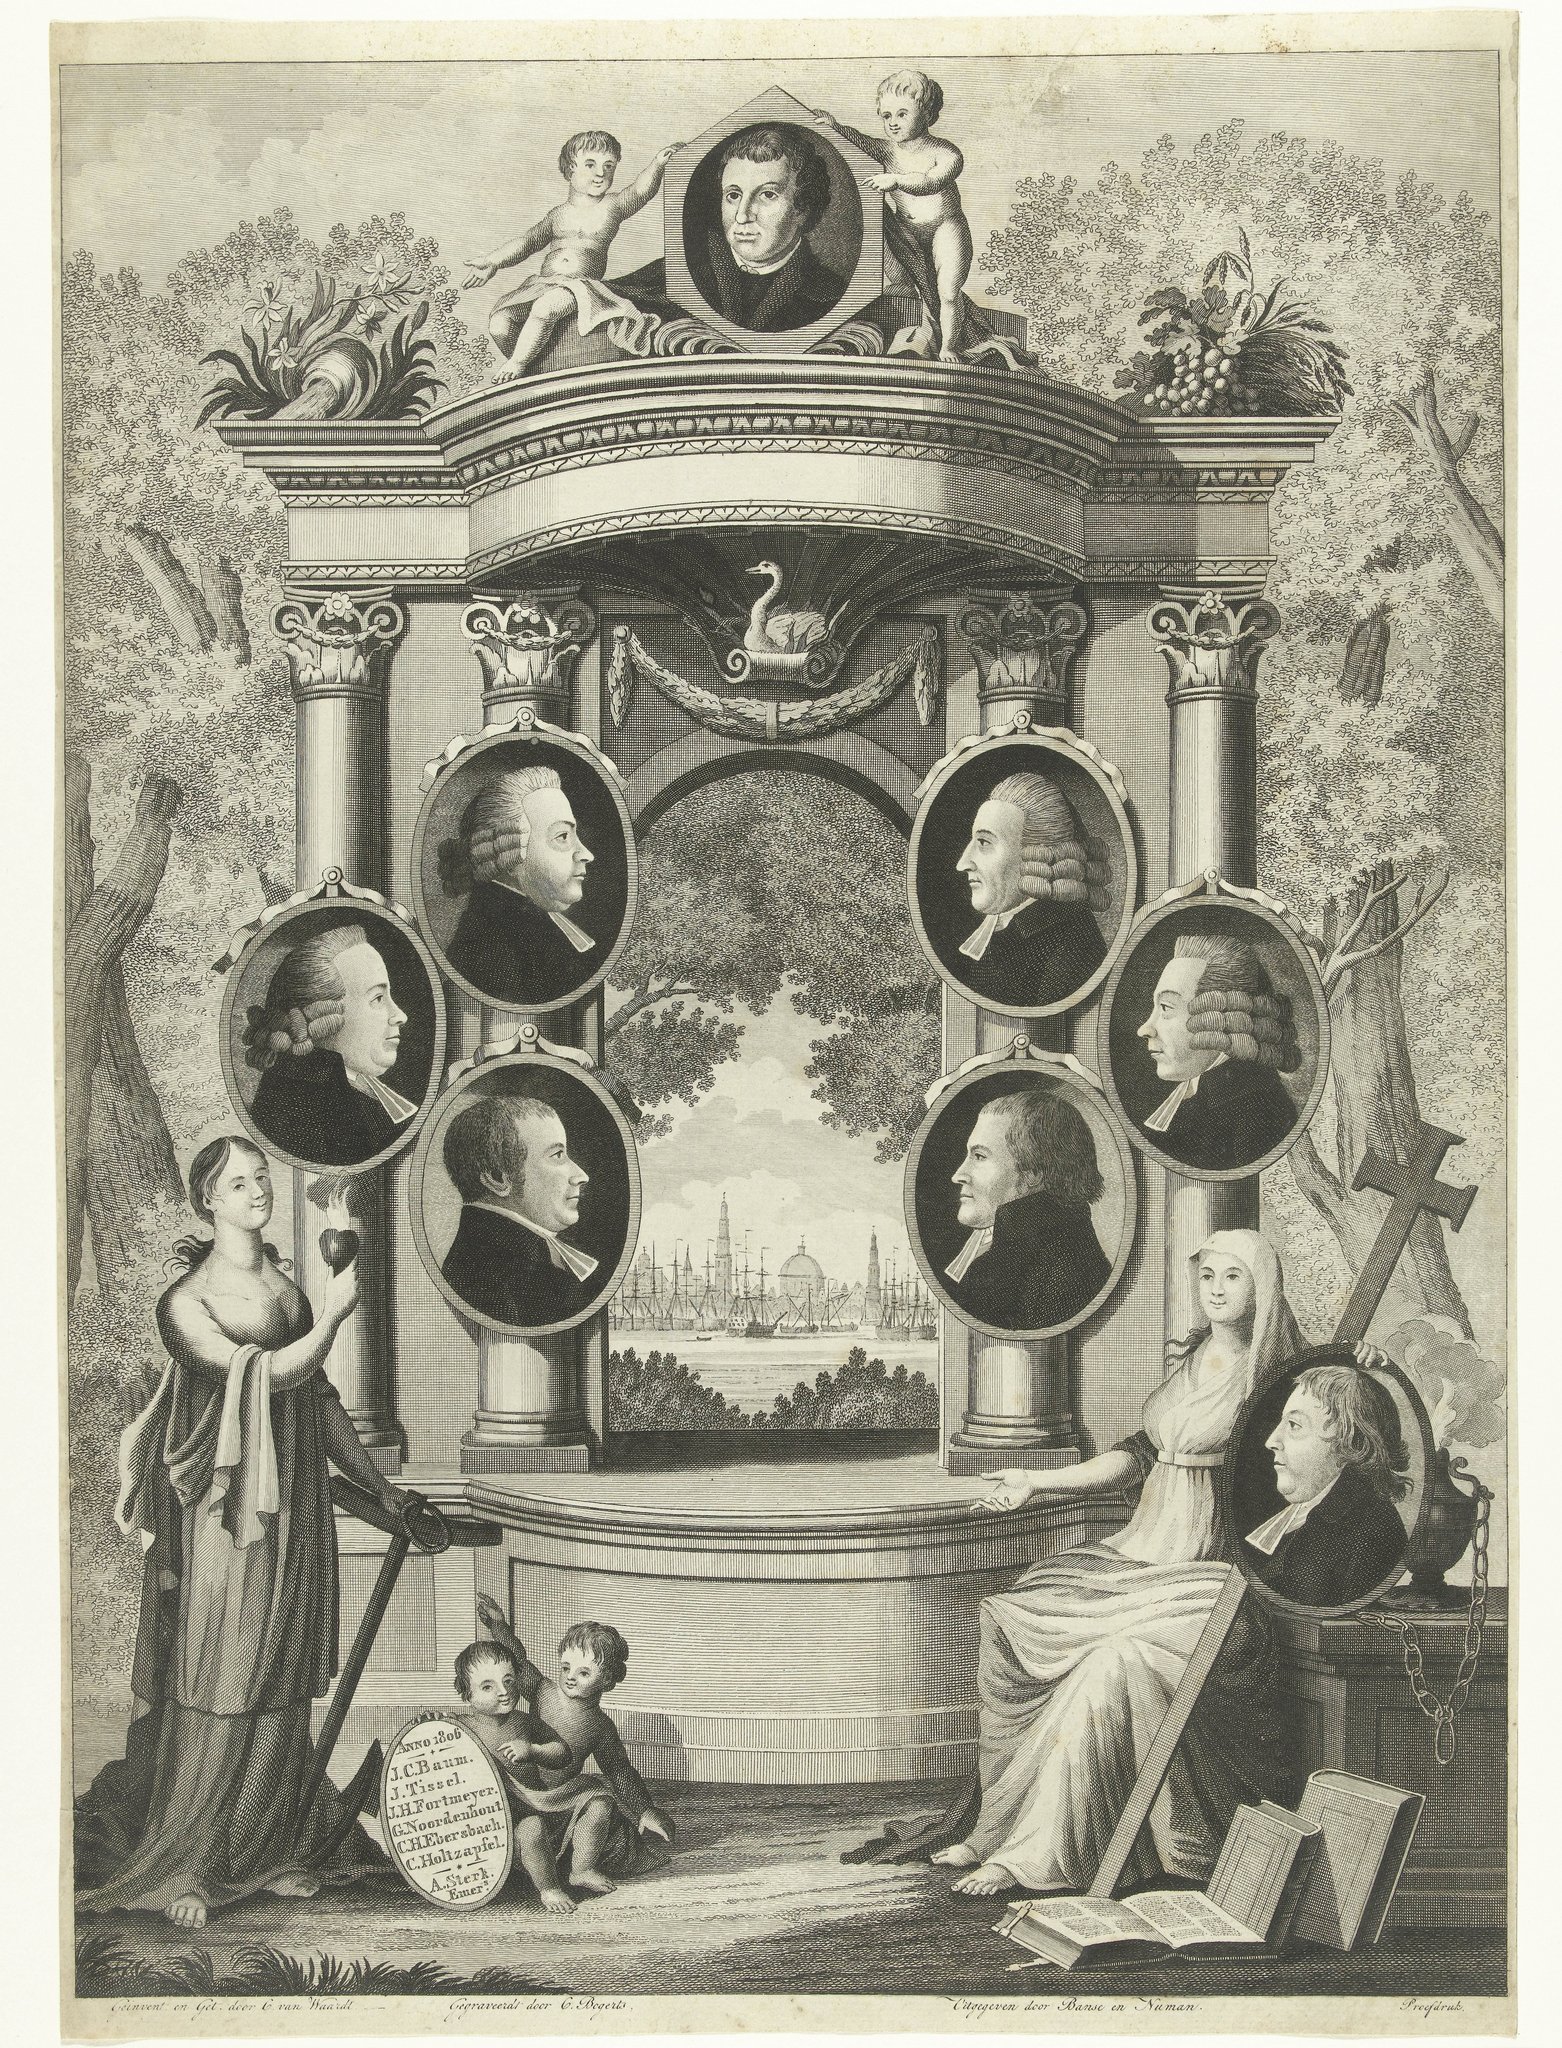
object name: print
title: Lutherse predikanten te Amsterdam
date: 1806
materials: paper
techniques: etching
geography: amsterdam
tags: christiaan van waardt, leiden, germany, priest, martin luther, faith, 'fides'; 'fede', 'fede catholica', 'fede christiana', 'fede christiana catholica' (ripa) ~ one of the three theological virtues, hope, 'spes'; 'speranza divina e certa' (ripa) ~ one of the three theological virtues, water-birds: swan, amsterdam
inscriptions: collector's mark: Lugt 2228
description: Allegorische voorstelling met een erepoort met uitzicht op de stad Amsterdam en de Lutherse Nieuwe Kerk. Boven op de poort staat een portret van Marten Luther. Eronder is een zwaan afgebeeld, het symbool van de Lutherse kerk in Nederland. Aan de poort hangen portretten van zes Amsterdamse Lutherse predikanten (links, van boven af: J.C. Baum, J.H. Fortmeijer en C.H. Eberbach, rechts, van boven af: J. Tissel, G. Noordenhout en en C. Holtzapffel). Voor de poort staan Hoop, met brandend hart en anker, en Geloof. Geloof houdt een zevende portret vast, van Augustus Sterk, befaamd predikant maar sinds 1802 niet meer actief (emeritaat).